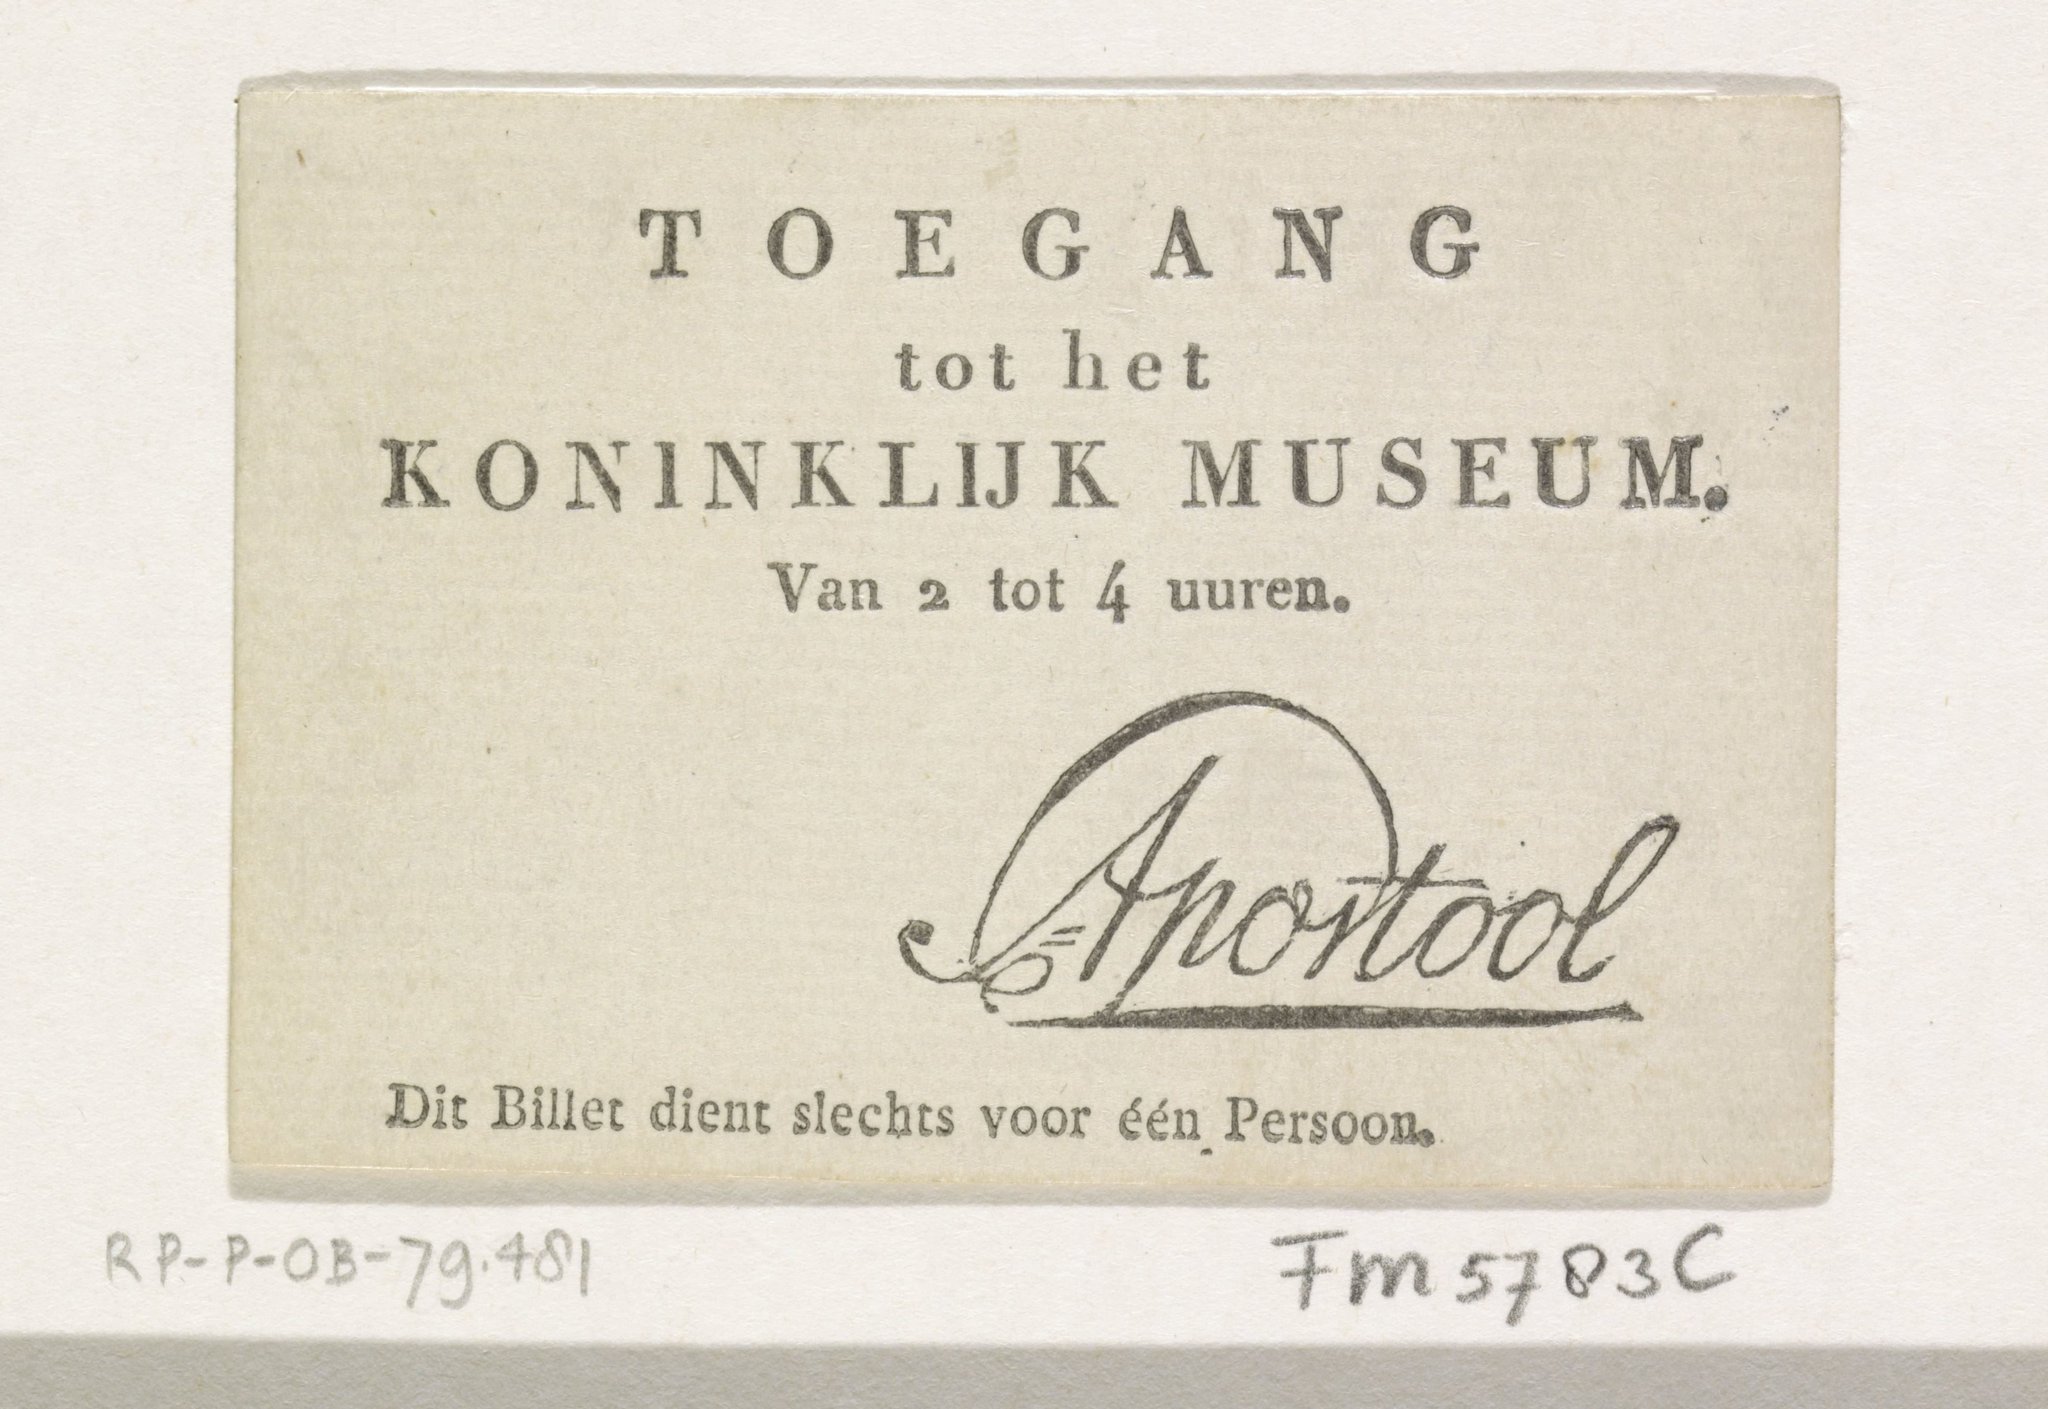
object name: admission ticket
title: Toegangskaart voor het Koninklijk Museum, 1809-1810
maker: Anonymous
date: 1809-1810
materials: paper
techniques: letterpress printing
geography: netherlands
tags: amsterdam, print maker, draughtsman, cornelis apostool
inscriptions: collector's mark: Lugt 2228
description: Toegangskaartje voor één persoon voor het Koninklijk Museum in Amsterdam, 1809-1810. Met de naam Apostool, directeur van het museum.